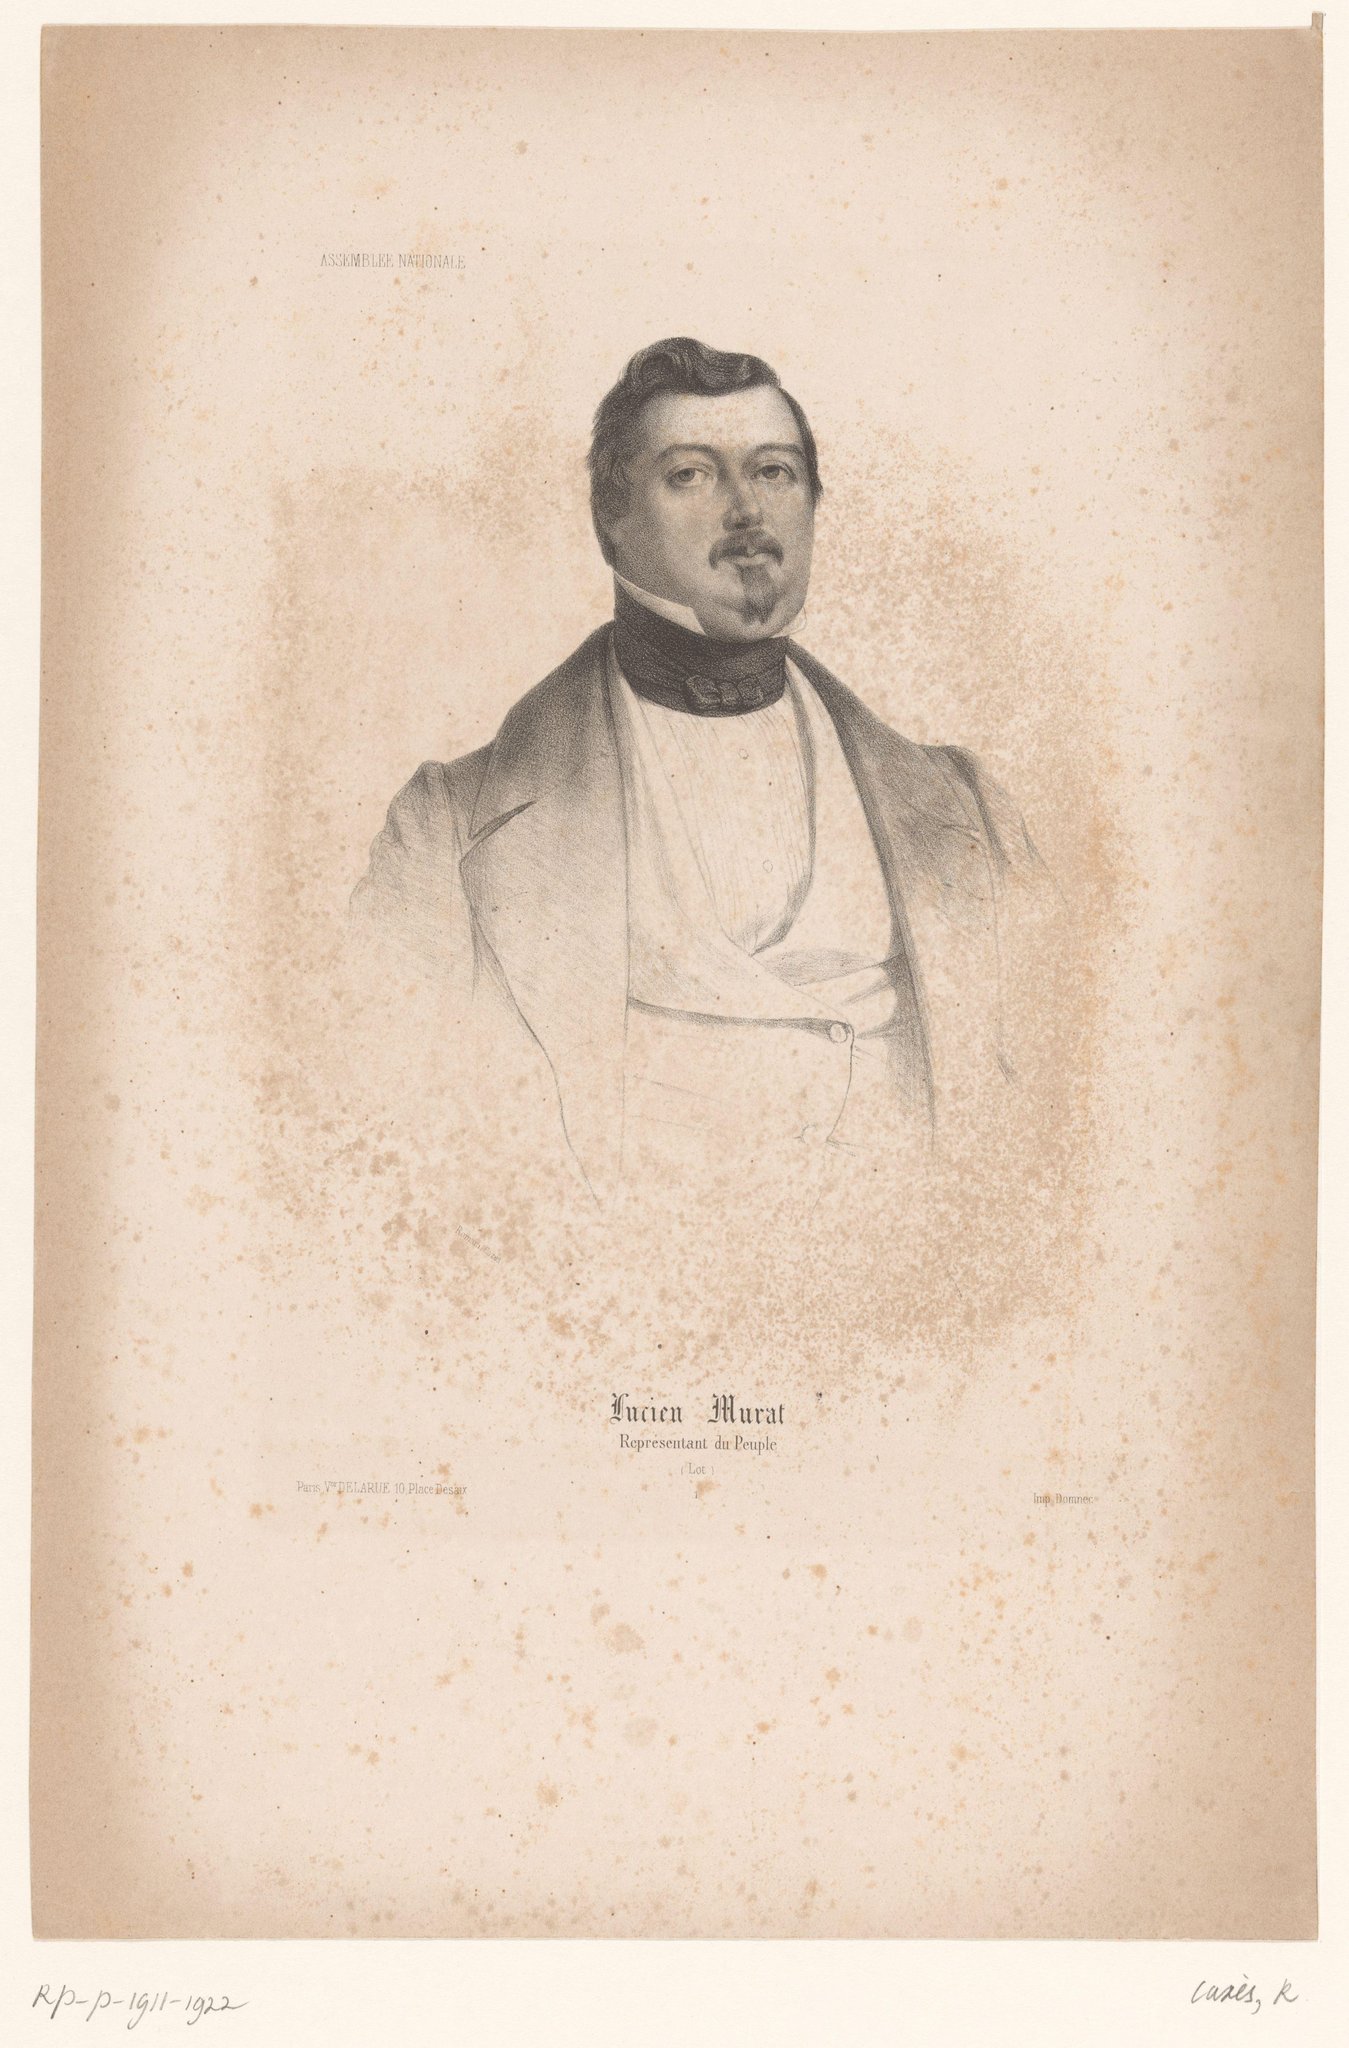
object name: print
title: Lucien Murat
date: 1848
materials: paper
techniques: lithograph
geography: paris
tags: paris, politician, historical persons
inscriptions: collector's mark: Lugt 2228a